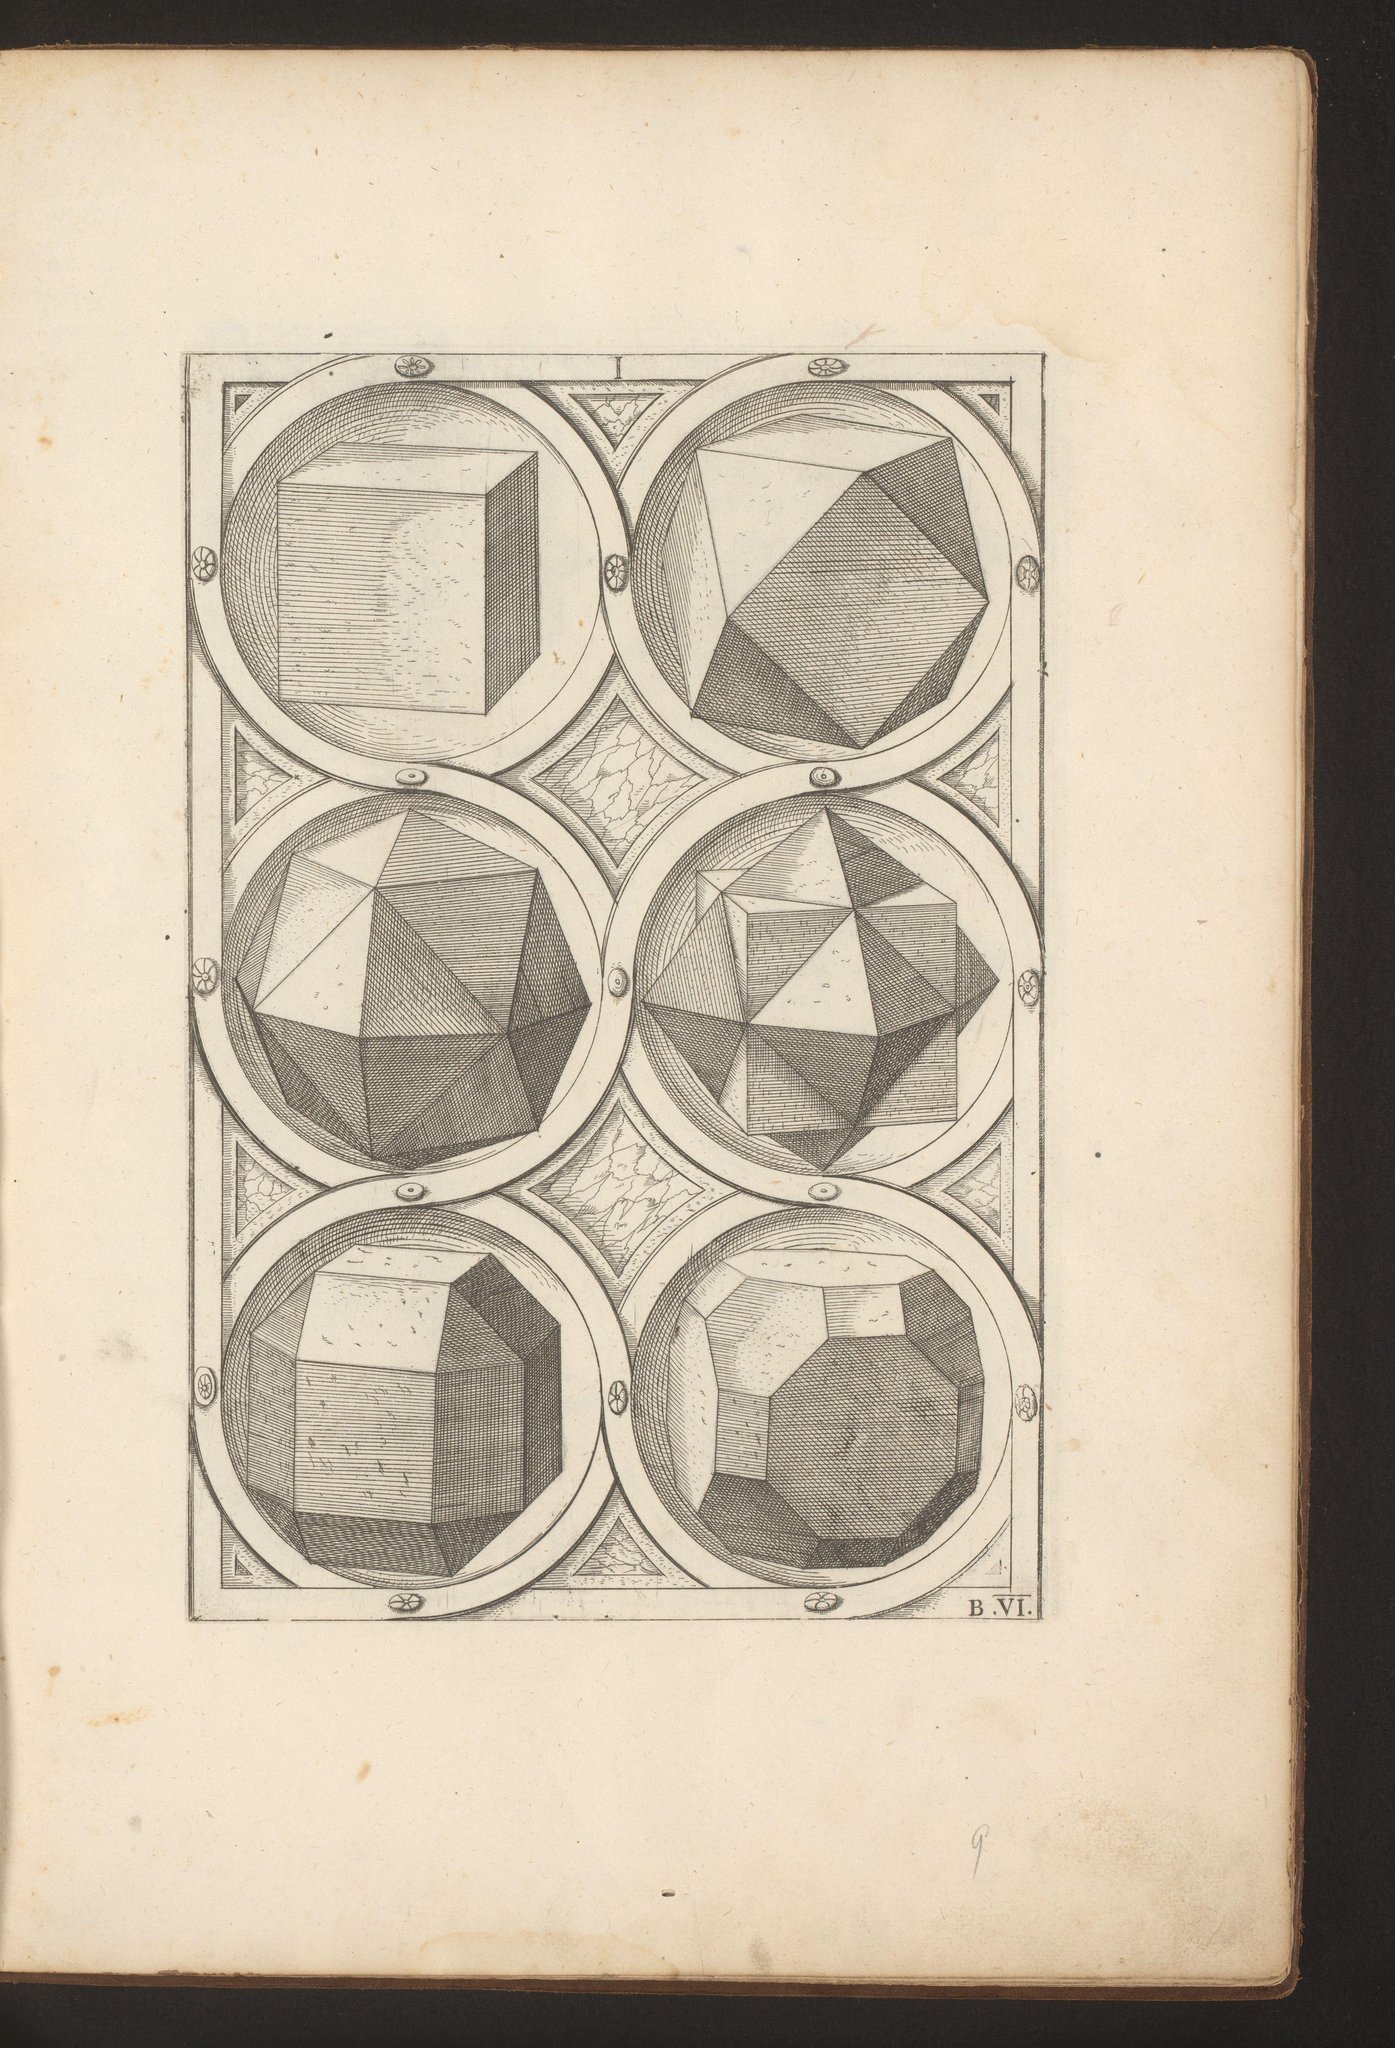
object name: book illustration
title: Zes veelvlakken met een hexaëder (kubus) als uitgangspunt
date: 1568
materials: paper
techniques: etching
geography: nuremberg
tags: hexahedron, cube, other polyhedrons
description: De geometrische figuren (polyhedra) worden van boven naar beneden complexer. Rechtsonder genummerd: B.VI. Deze prent maakt deel uit van een boek.